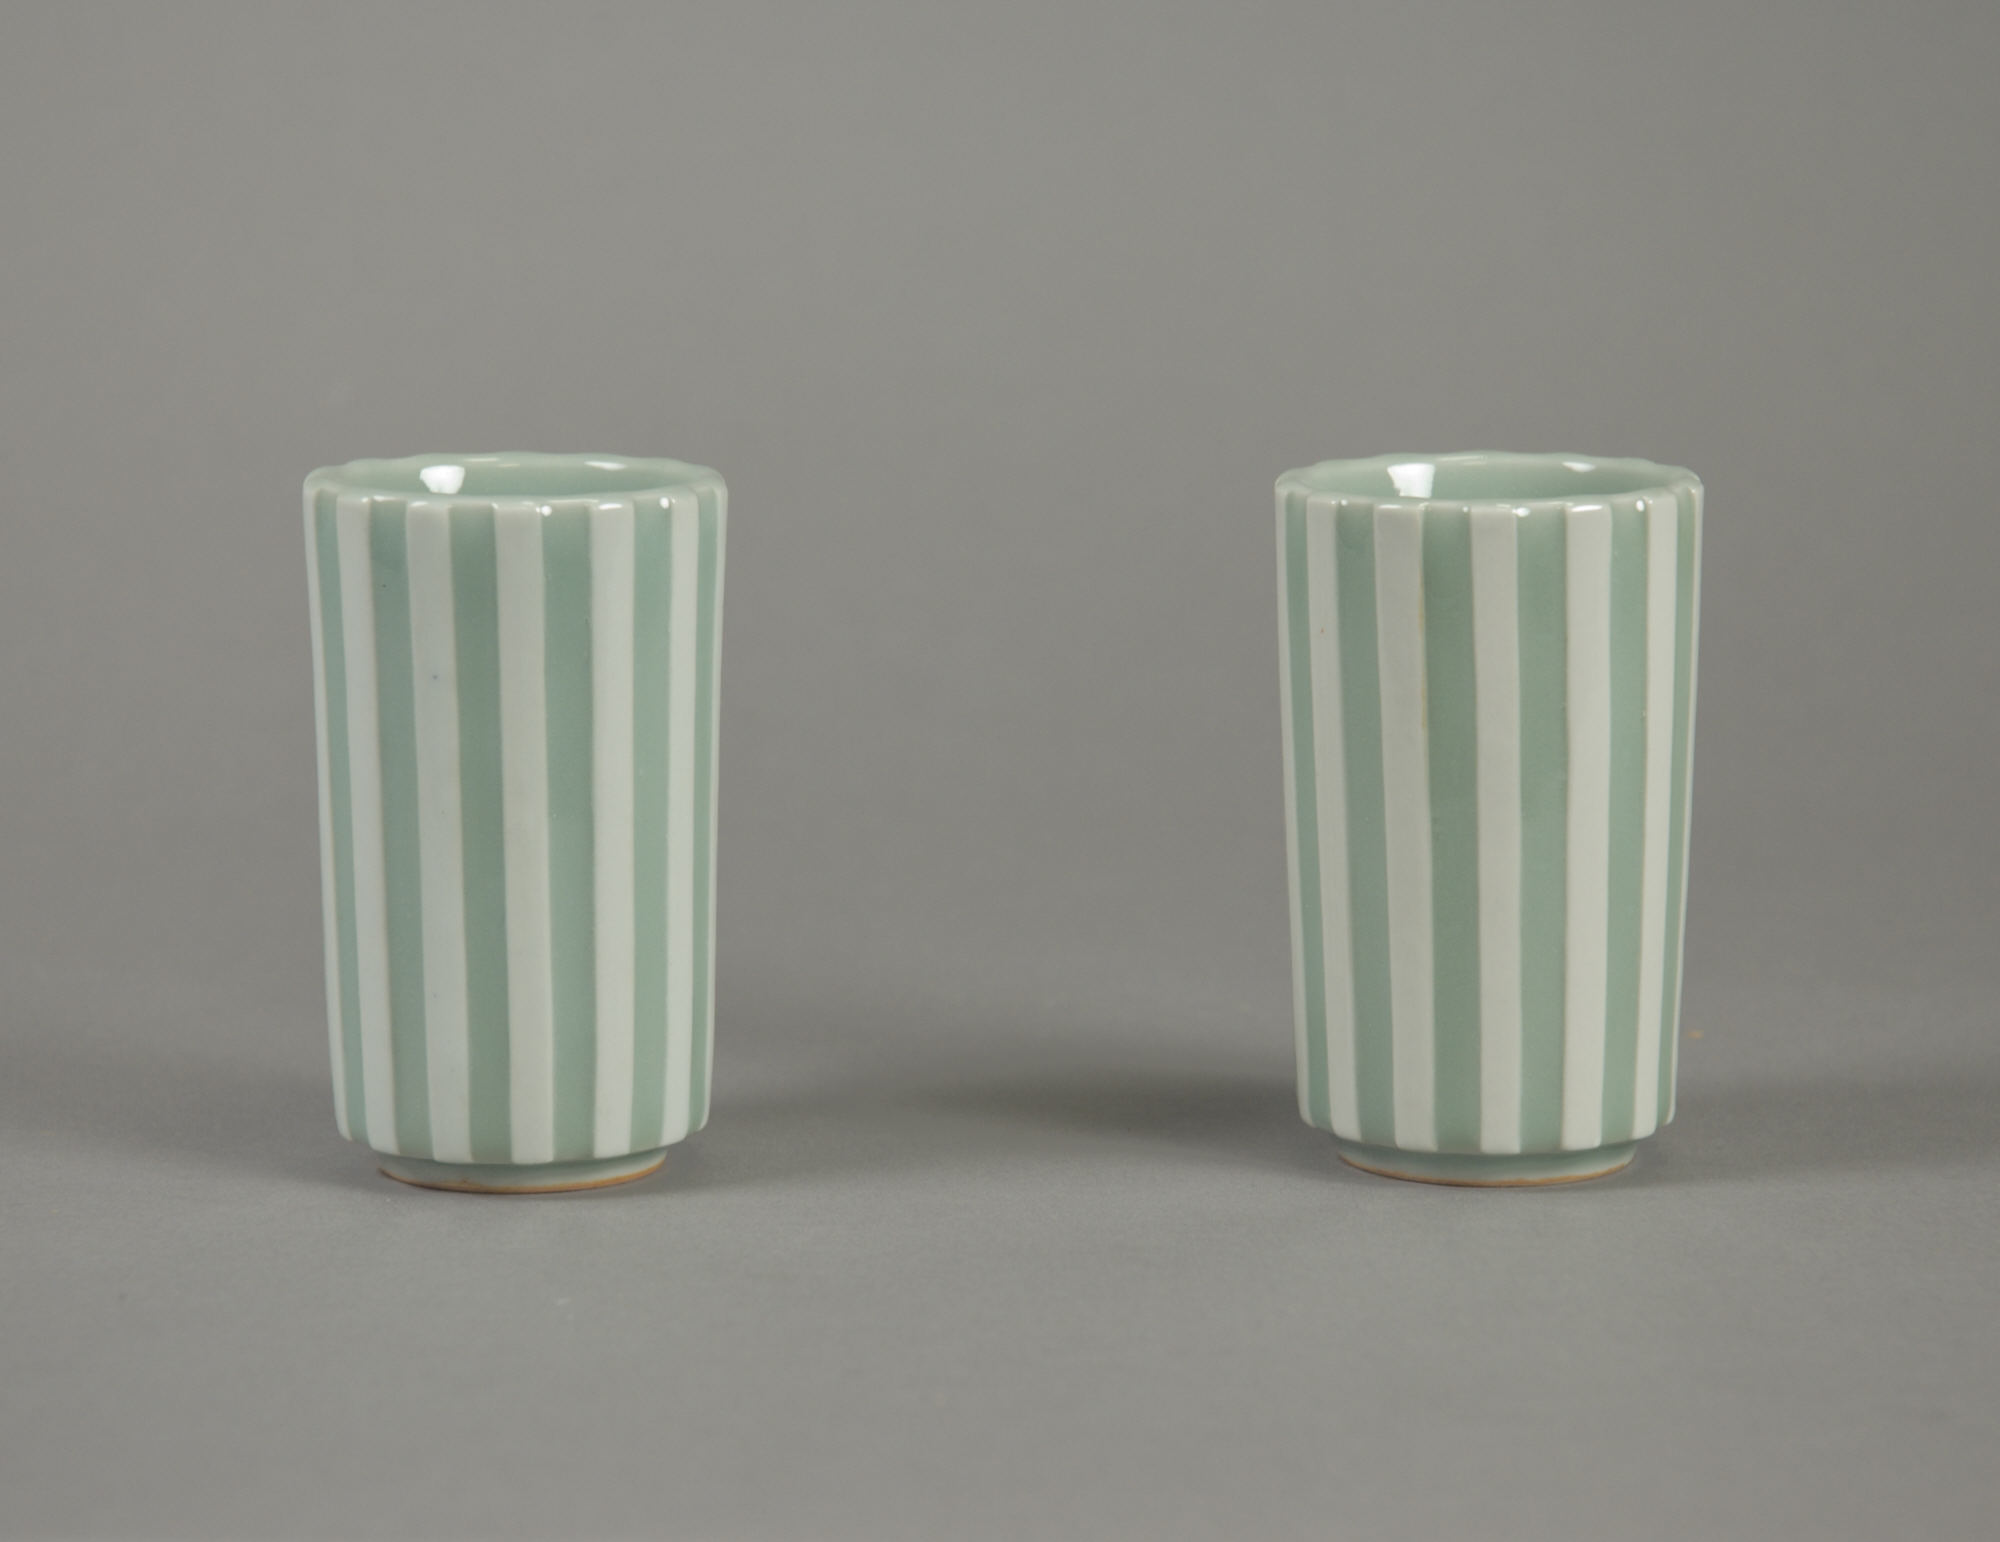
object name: cup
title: Cup with Striped Design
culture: japanese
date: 1701-1800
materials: porcelain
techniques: underglaze